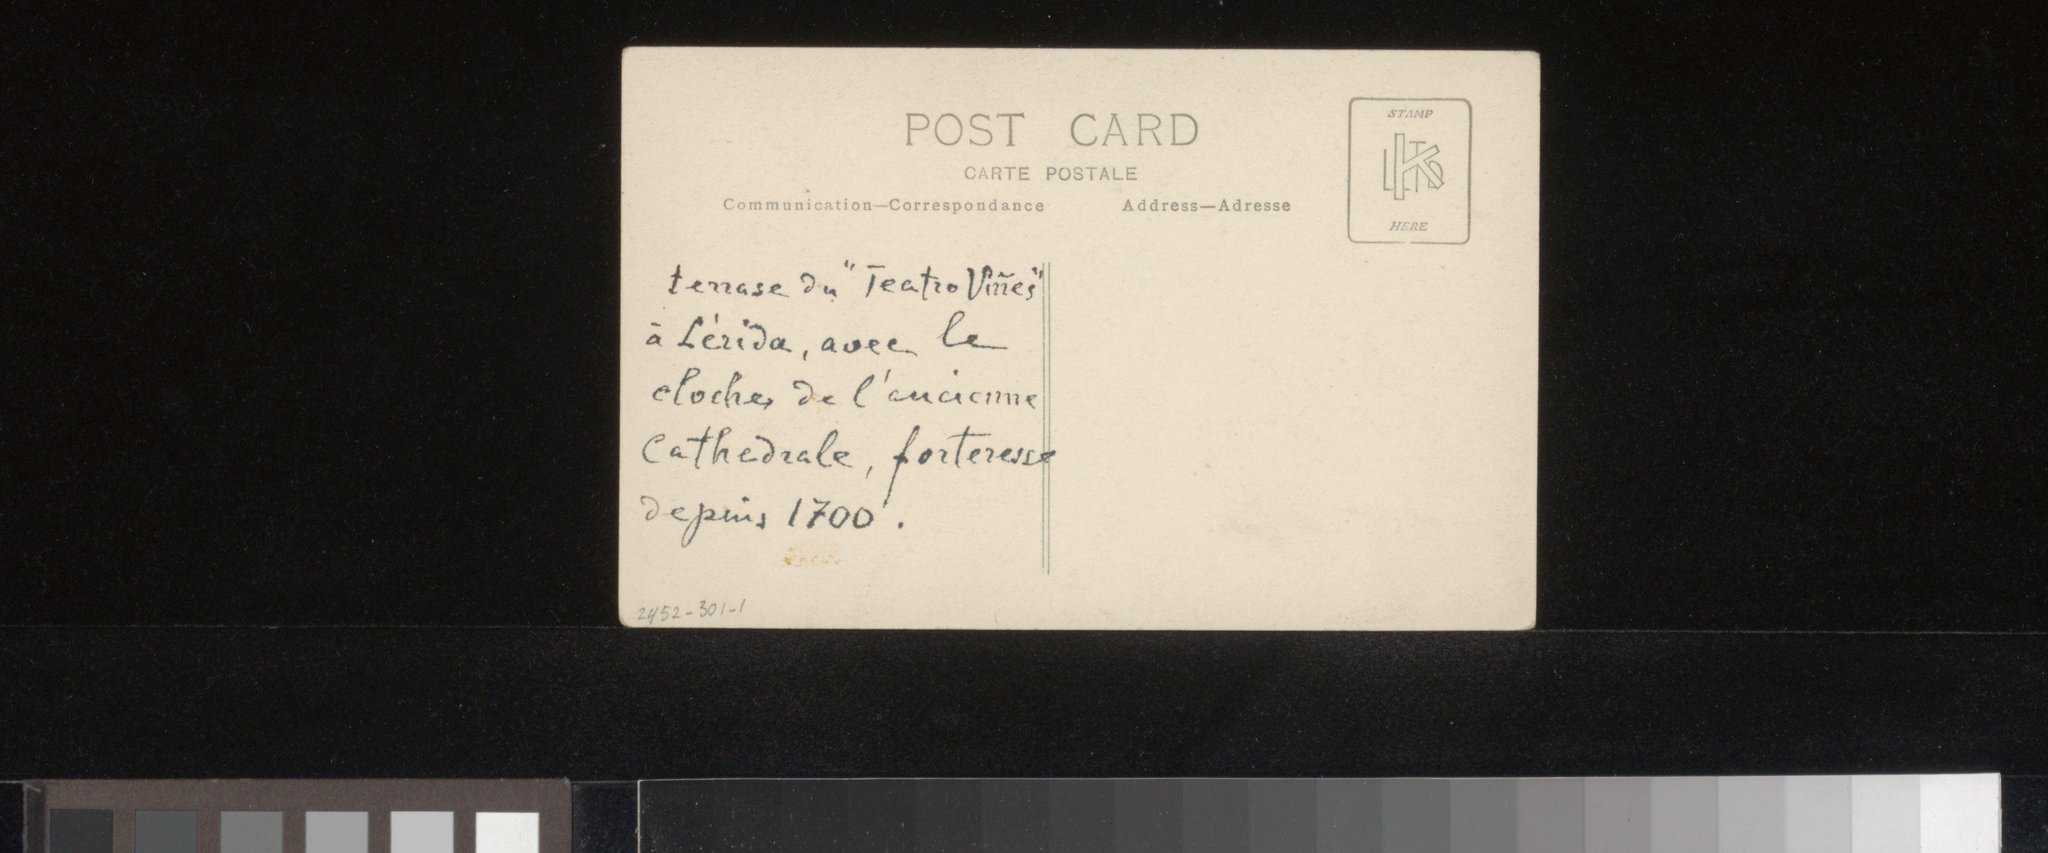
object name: ansichtkaart, prentbriefkaart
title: Prentbriefkaart aan Andries Bonger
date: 1928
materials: cardboard, ink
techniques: gelatin silver print, pen, writing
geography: lerida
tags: paris, painter, print maker, draughtsman, odilon redon, amsterdam, andries bonger